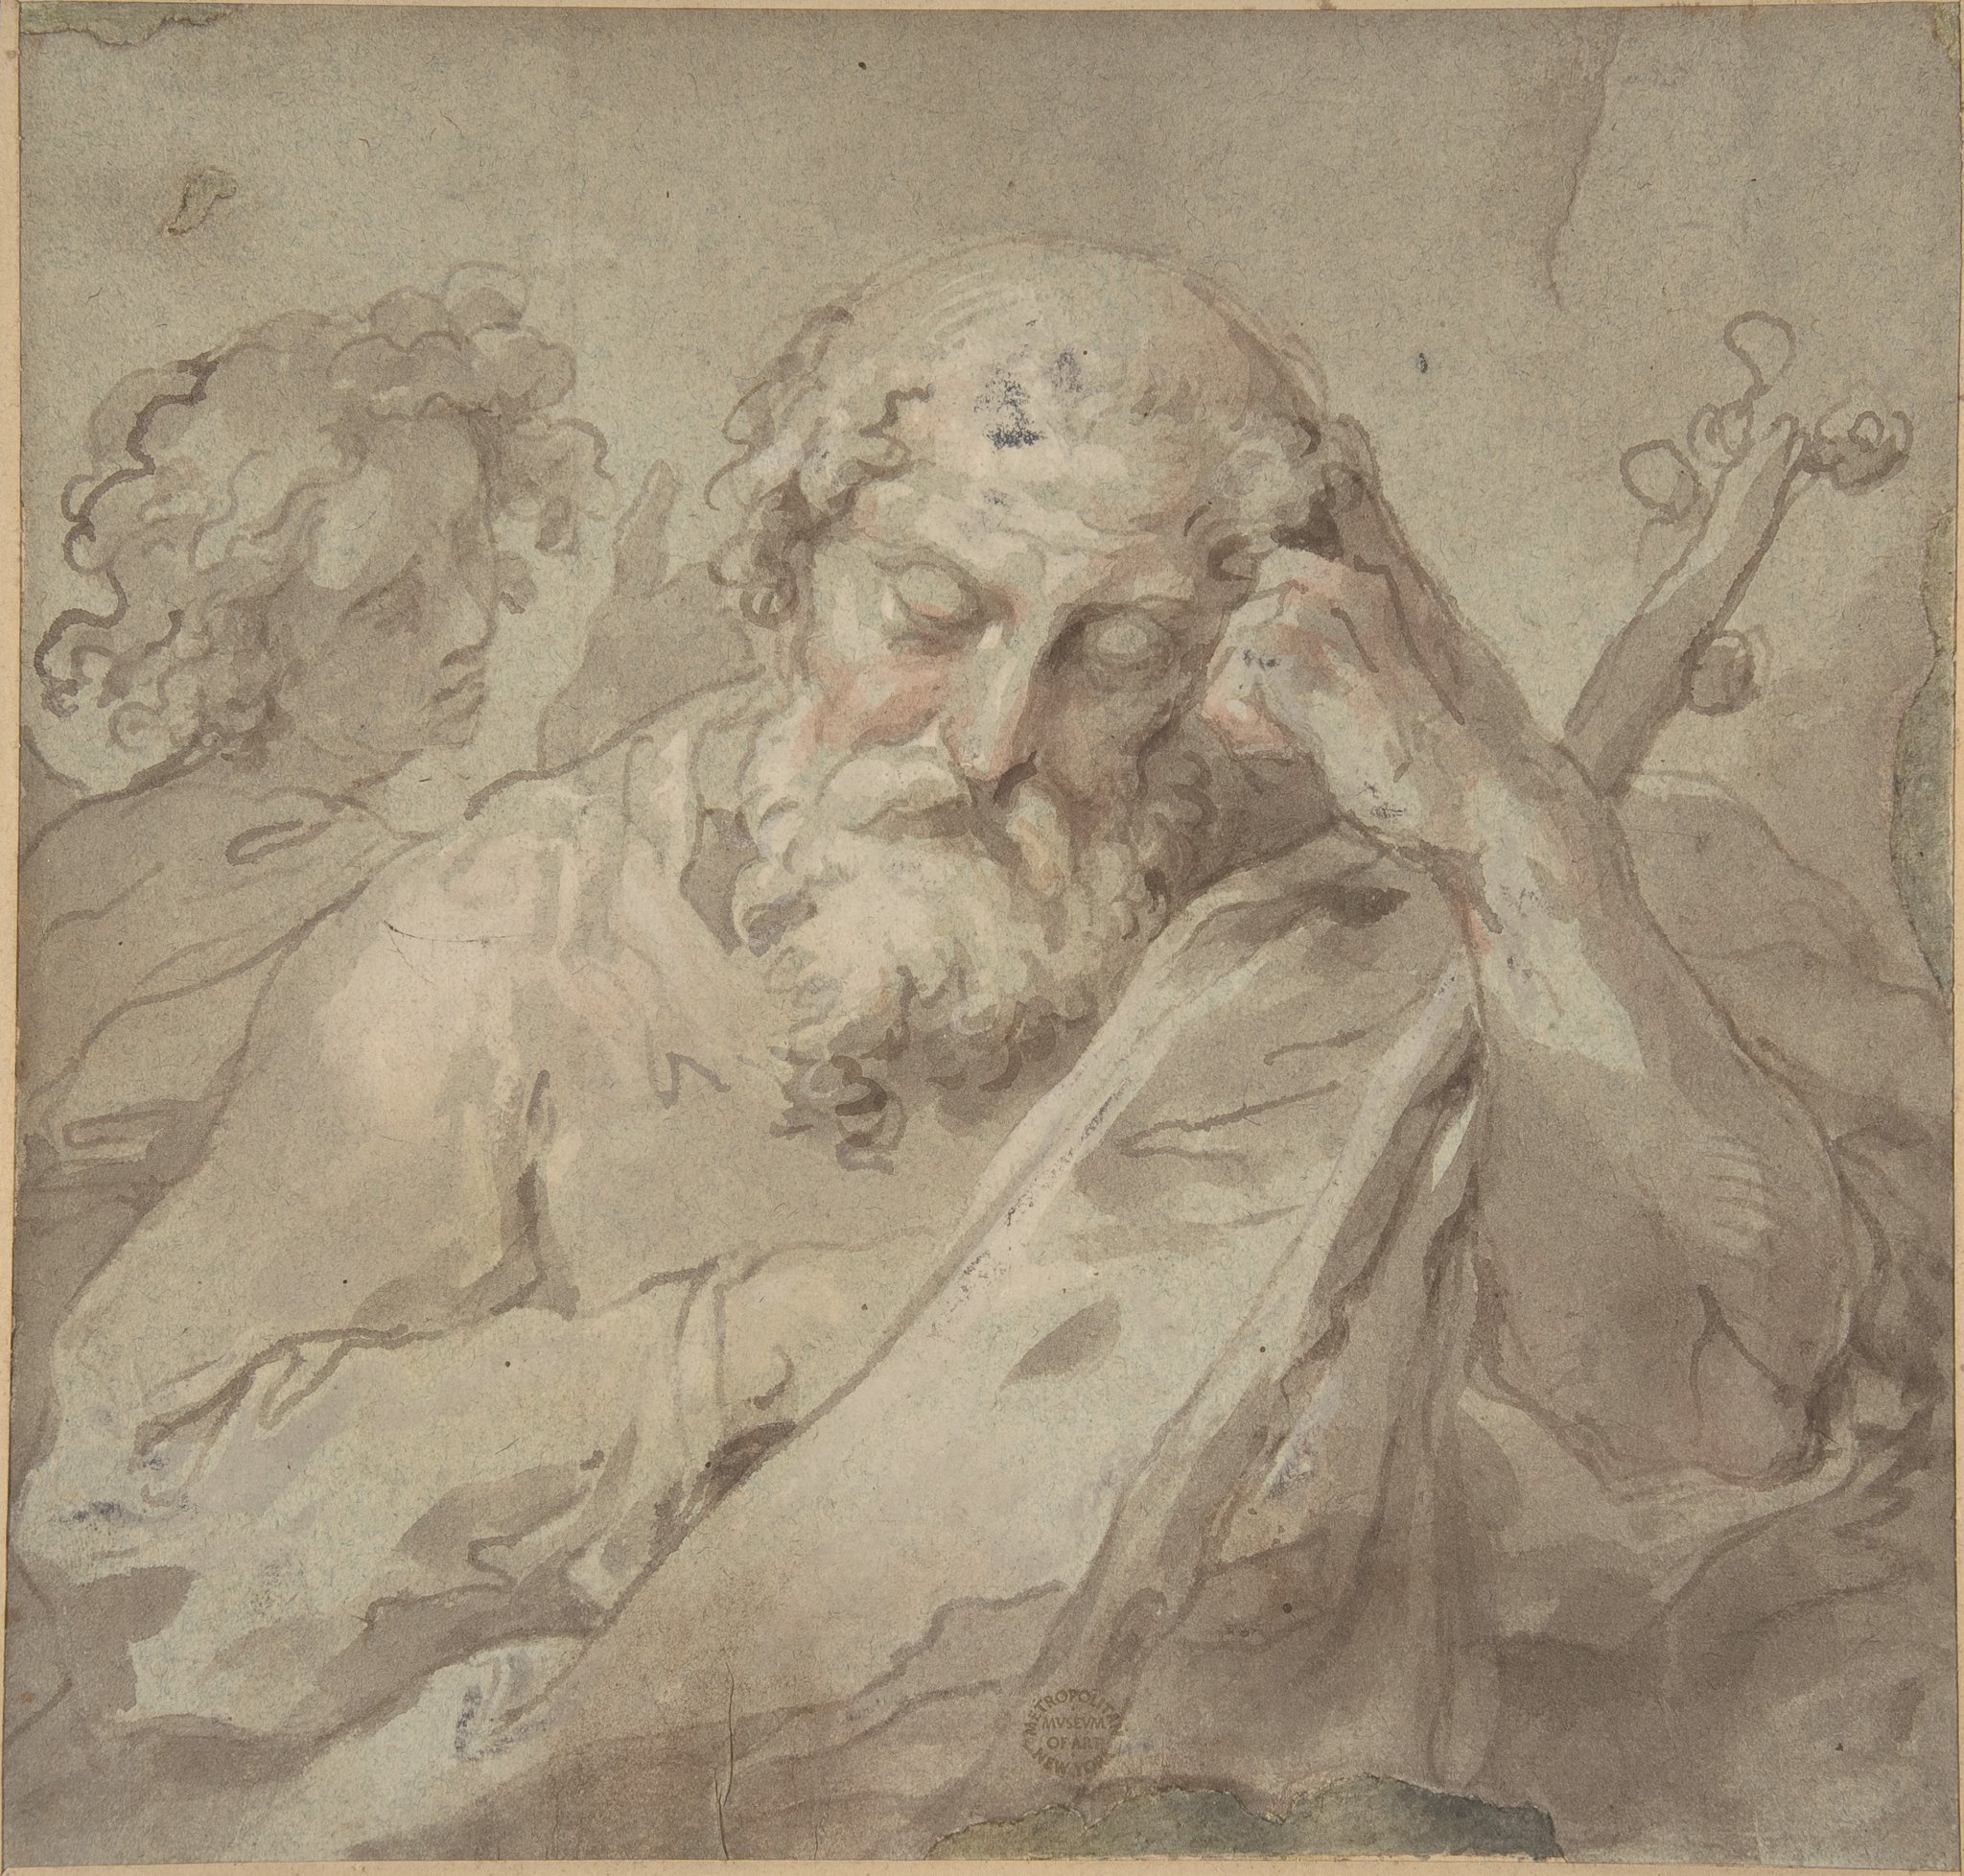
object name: drawing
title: The Dream of Saint Joseph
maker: anonymous, italian, 18th century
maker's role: artist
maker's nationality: italian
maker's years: 1700-1800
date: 1701-1800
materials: gouache, ink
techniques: brush, highlighting, wash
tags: sleeping,saint joseph